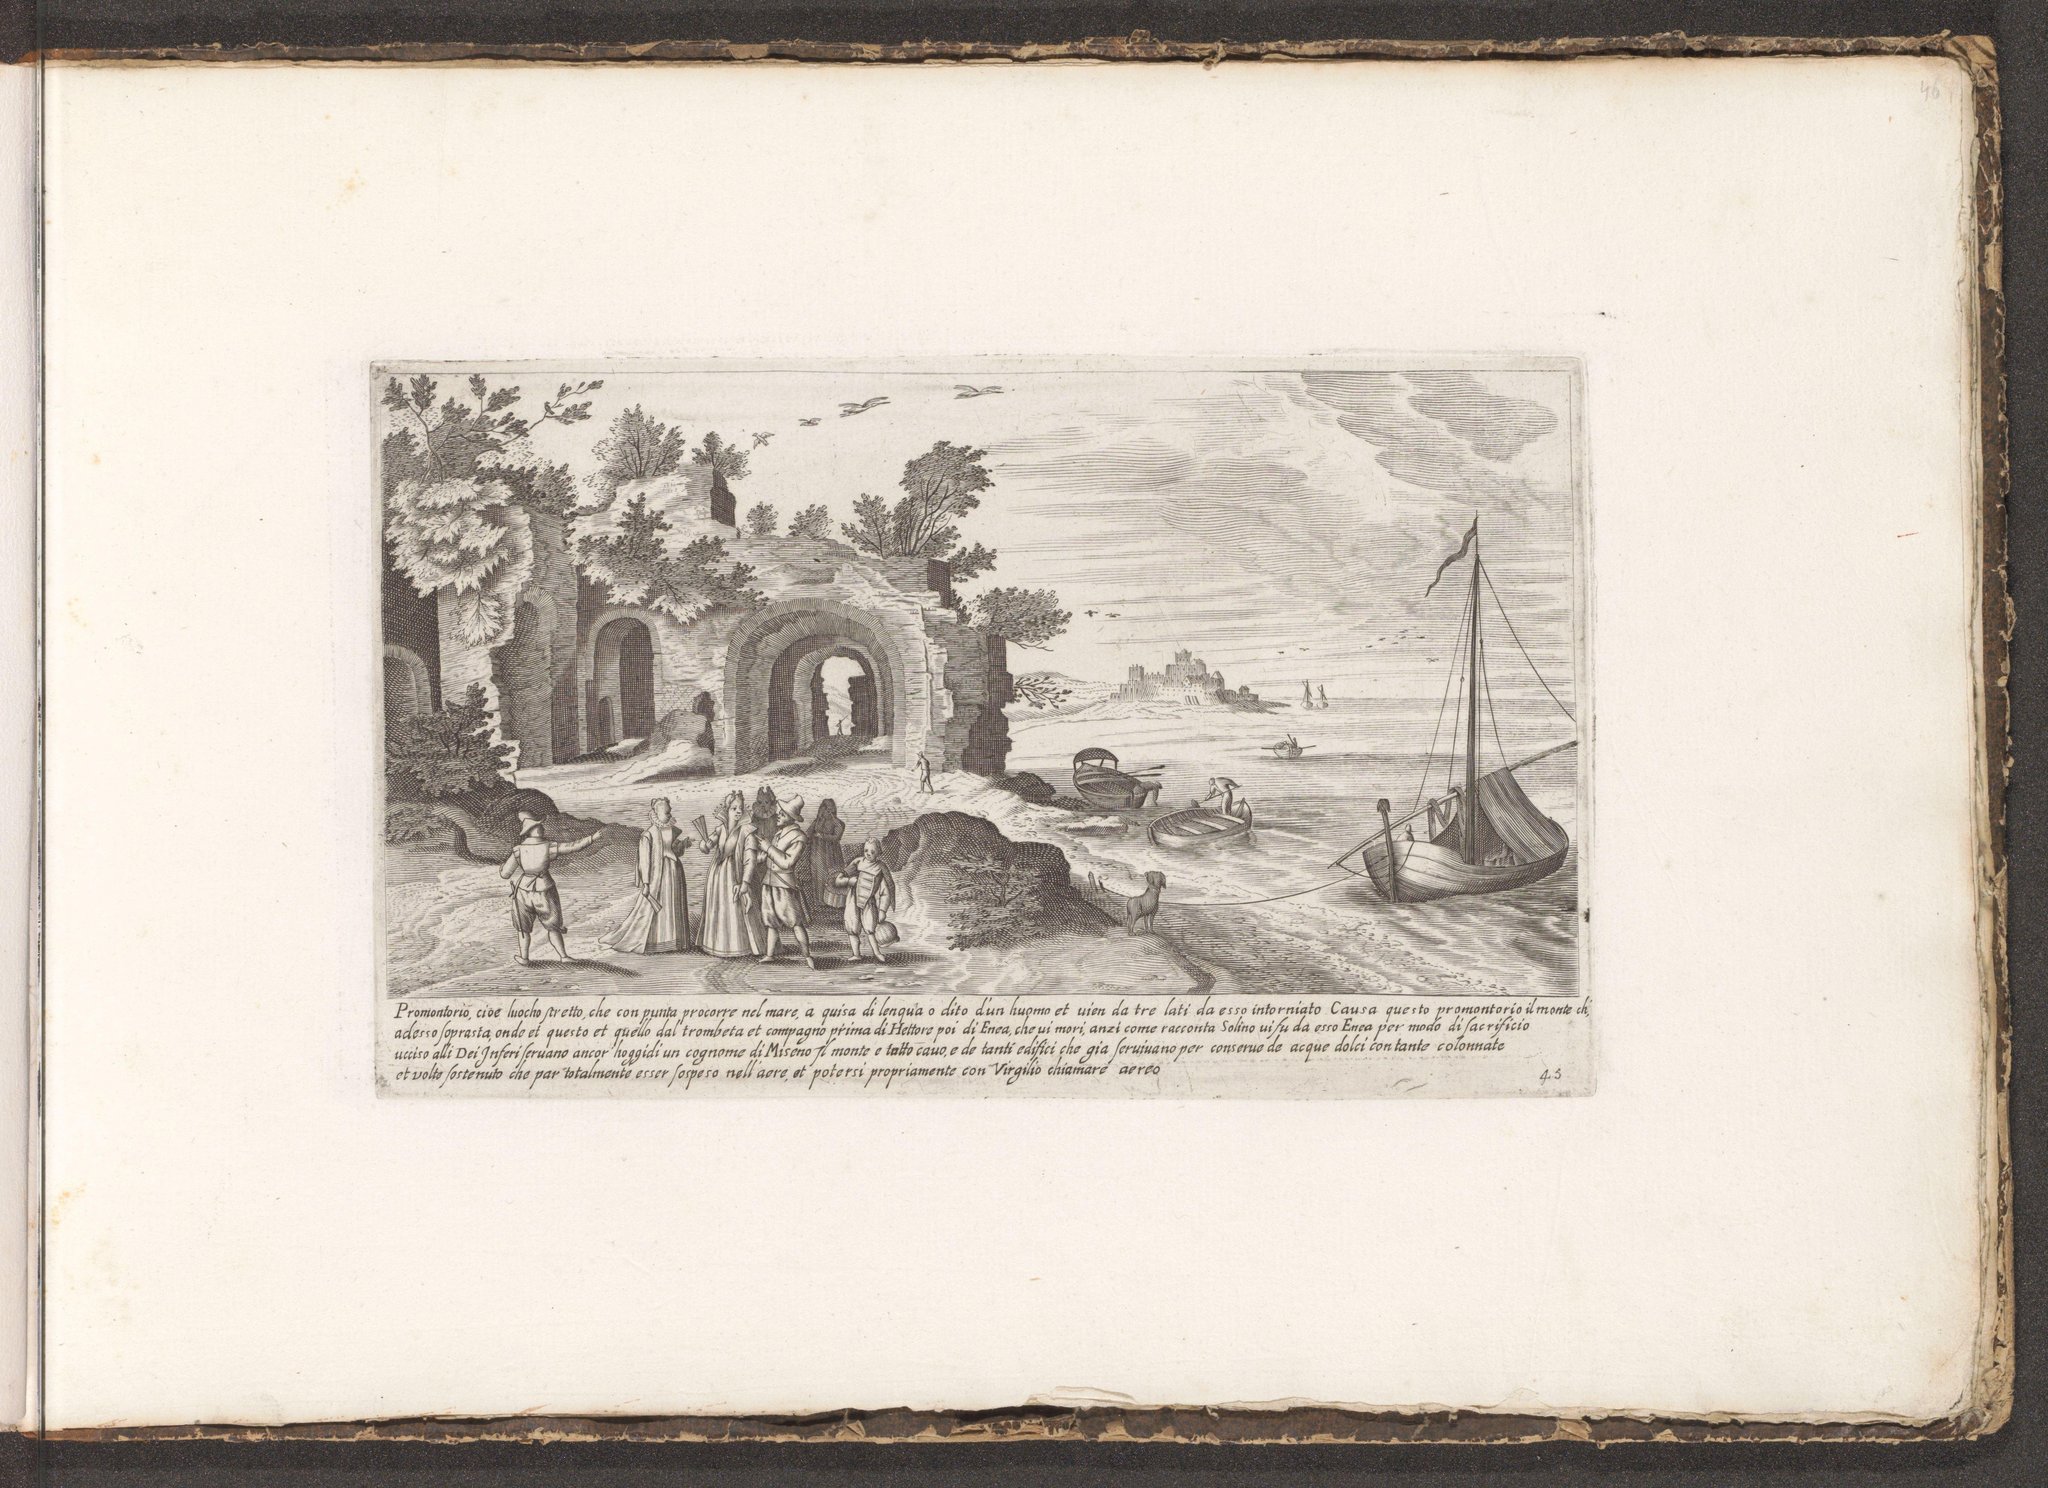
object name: album leaf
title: Ruïnes bij Misenum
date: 1680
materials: paper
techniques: engraving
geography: prague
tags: miseno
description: Ruïnes bij Misenum, genoemd naar Misenus, metgezel van Hector en hoornblazer van Aeneas die hier verdronk en begraven werd. Het lag op de plek van het huidige Miseno. Rechts enkele boten. Op de voorgrond een gezelschap van heren en dames. Een jongen sjouwt een mand en twee kruiken. In de ondermarge vier regels tekst in het Italiaans. De prent maakt deel uit van een album.